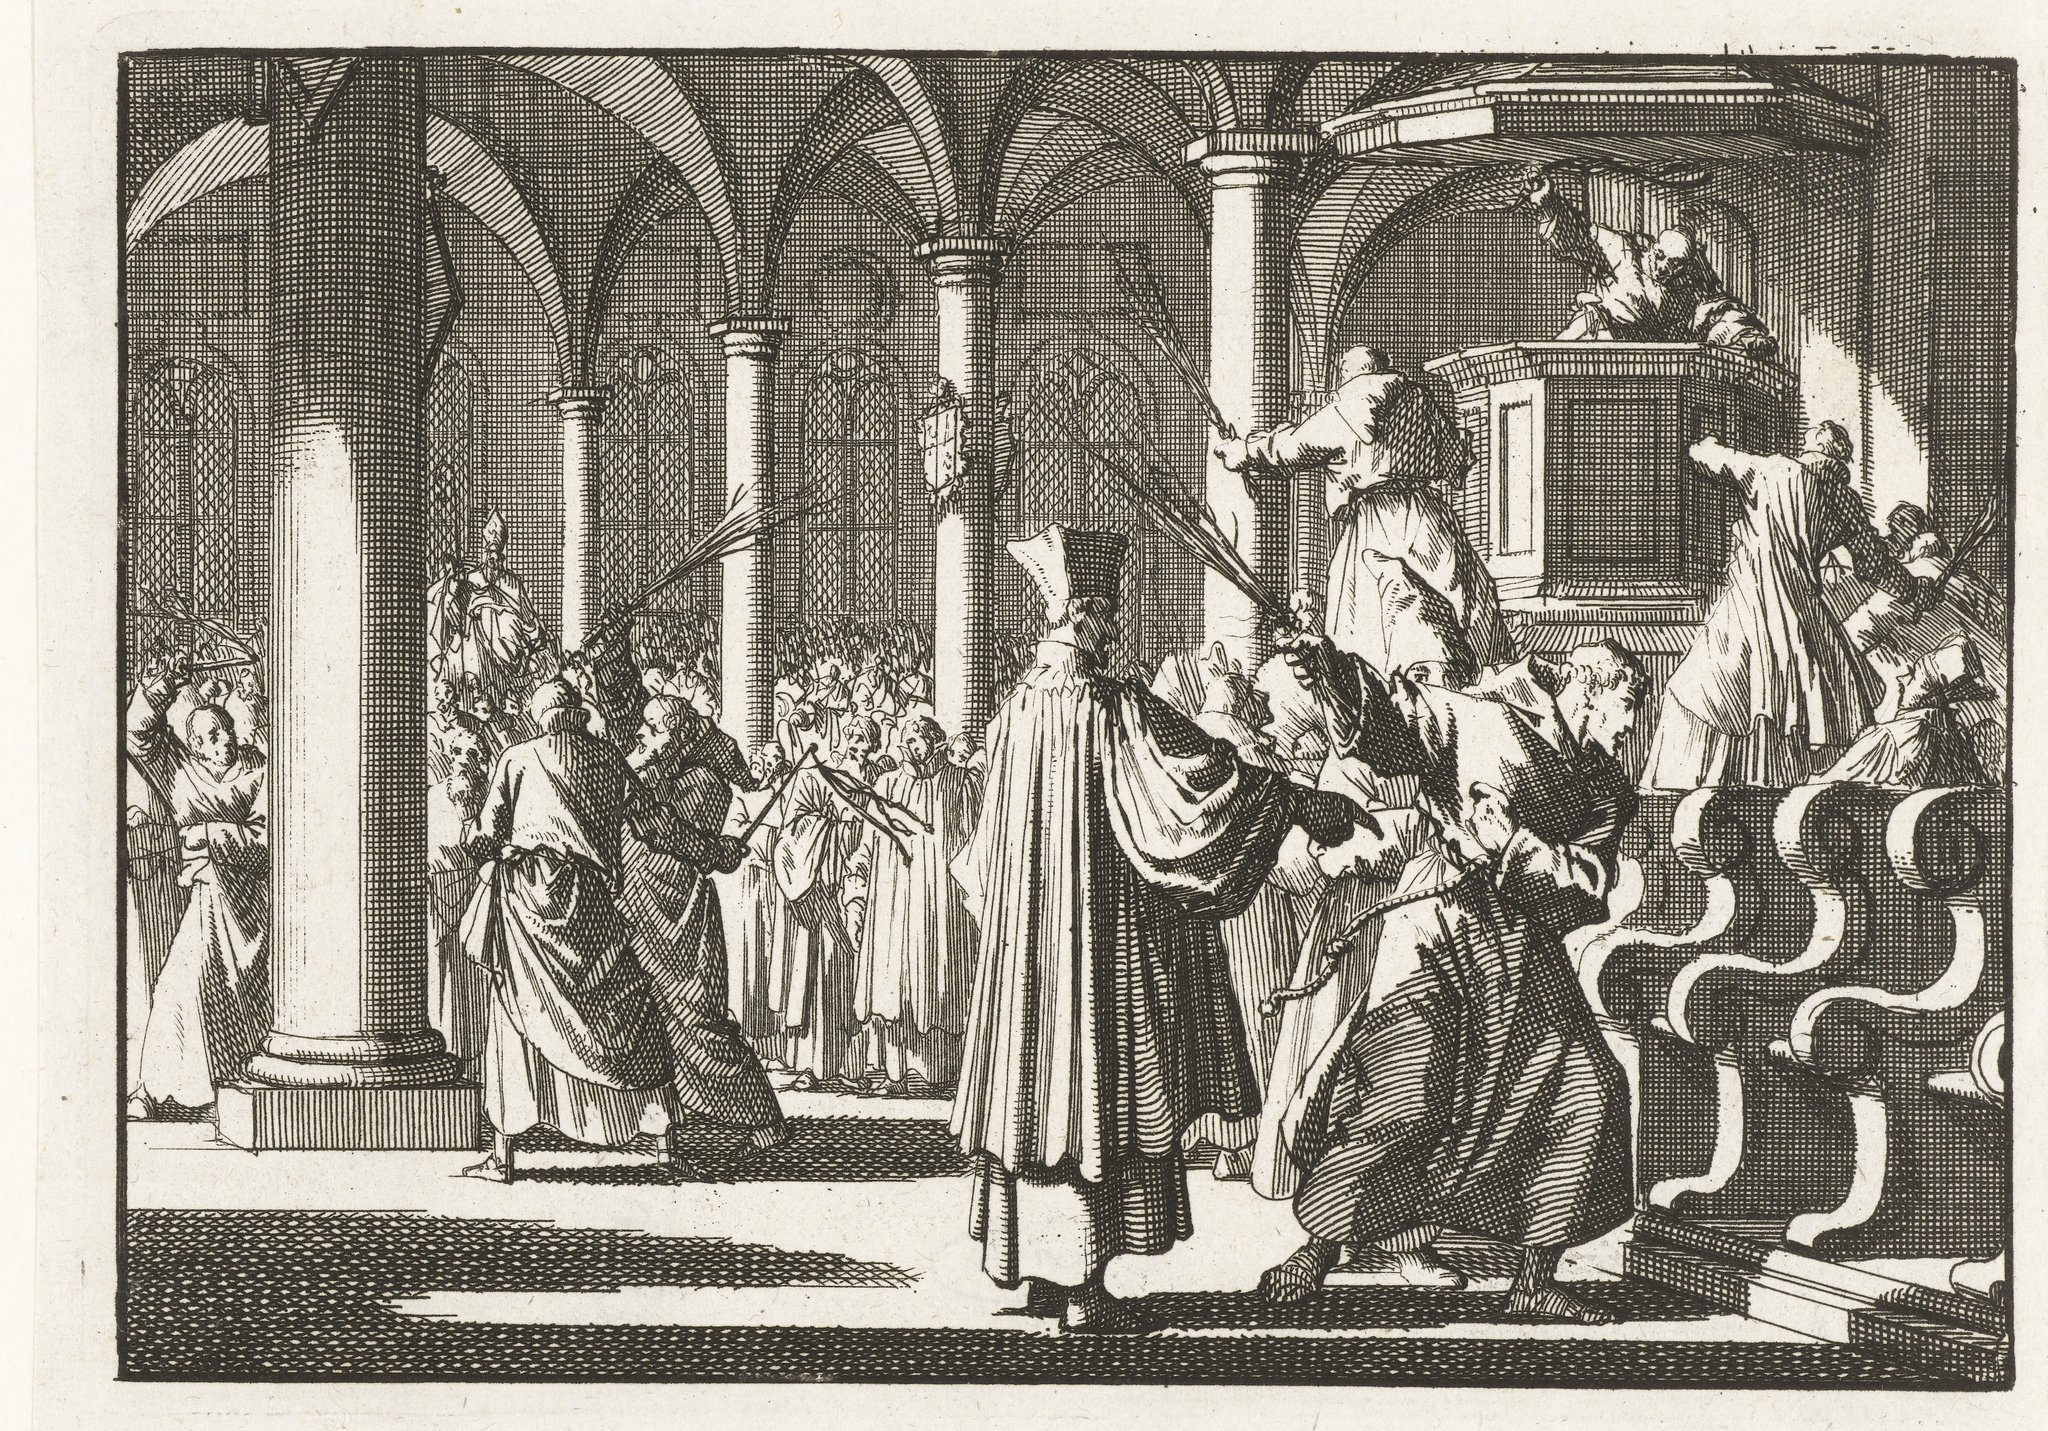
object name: print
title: Herinwijding van de Sint-Bavo te Haarlem, 1573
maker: jan luyken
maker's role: draughtsman, print maker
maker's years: 1649-1712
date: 1696-1698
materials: paper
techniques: etching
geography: northern netherlands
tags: inauguration, consecration of person(s) ~ church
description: Gebruikt als illustratie in: T. Schrevelius, Harlemias, of Eerste stichting der stad Haarlem, J. Marshoorn, Haarlem 1754, p. 139. Deze prent gemaakt voor en eerst gebruikt in Gottfrieds Historische kronyck van 1698. Niet in Frederik Muller; door het RPK toegevoegd nummer.